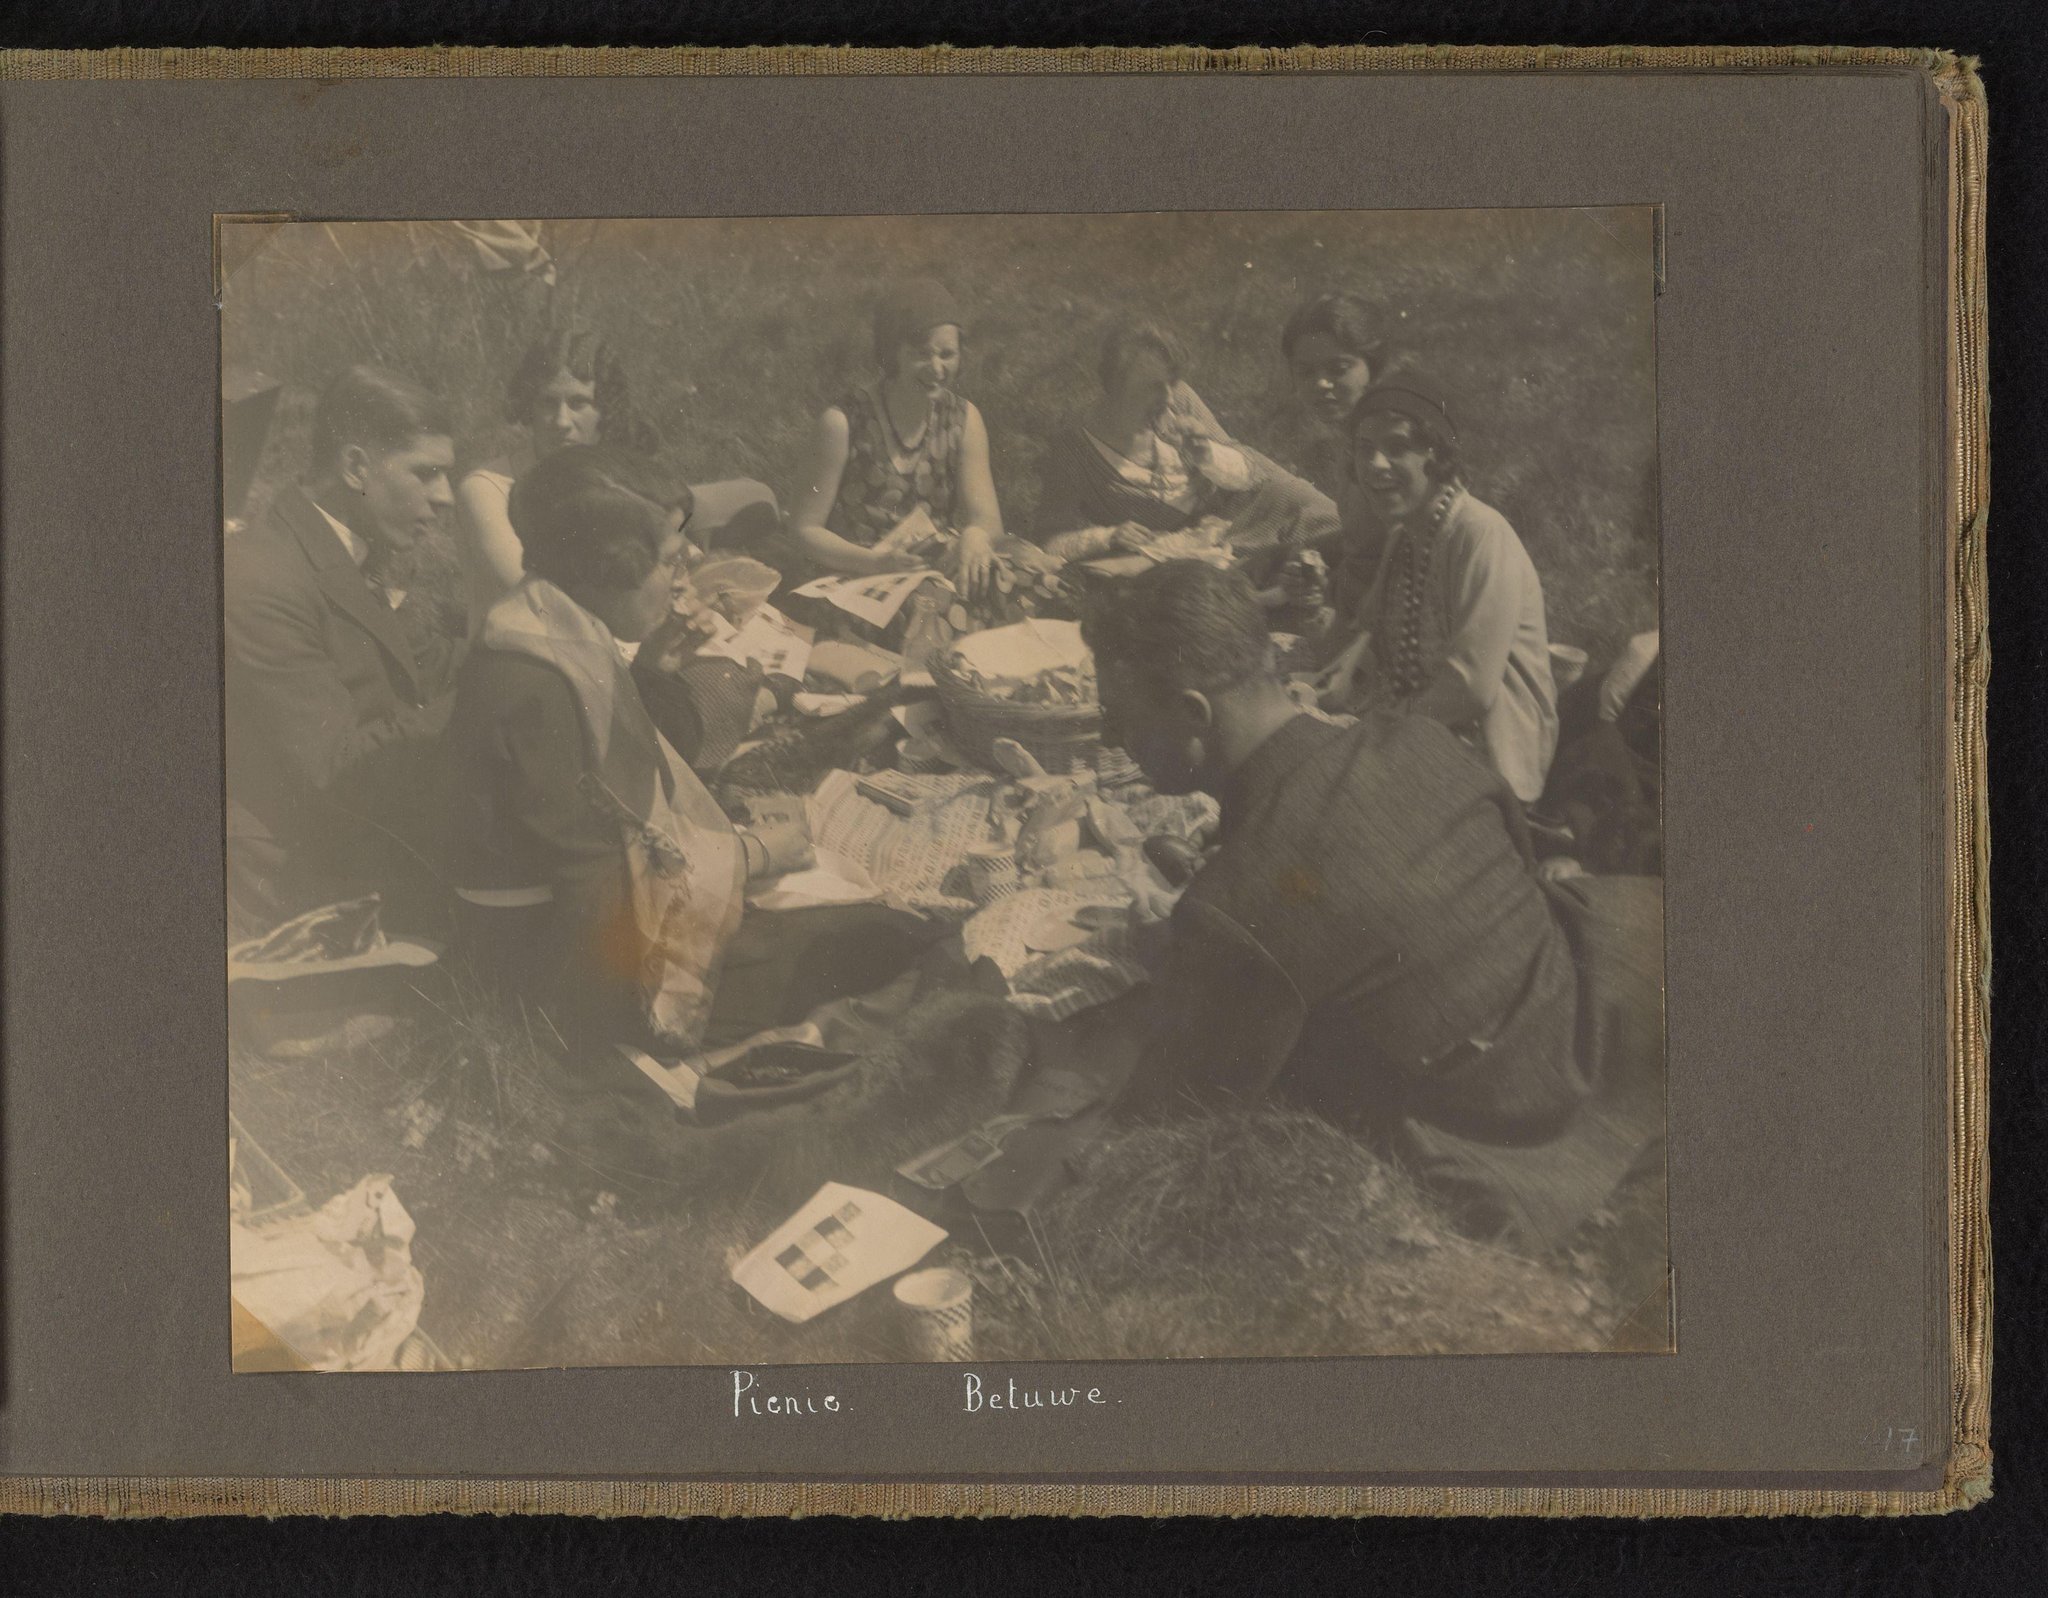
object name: photograph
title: Picknick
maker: Anonymous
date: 1905-1931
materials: cardboard, photographic support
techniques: gelatin silver print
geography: netherlands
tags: outing, pleasure trip, (family) meal - cc - out of doors, student life, celebration meal, feast, banquet - cc - out of doors, netherlands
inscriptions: inscription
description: Albumblad met een foto van een picknick tijdens een uitstapje met vrienden in de auto naar de Betuwe, mei 1931. Onderdeel van fotoalbum 'Studentenalbum Indologen'.